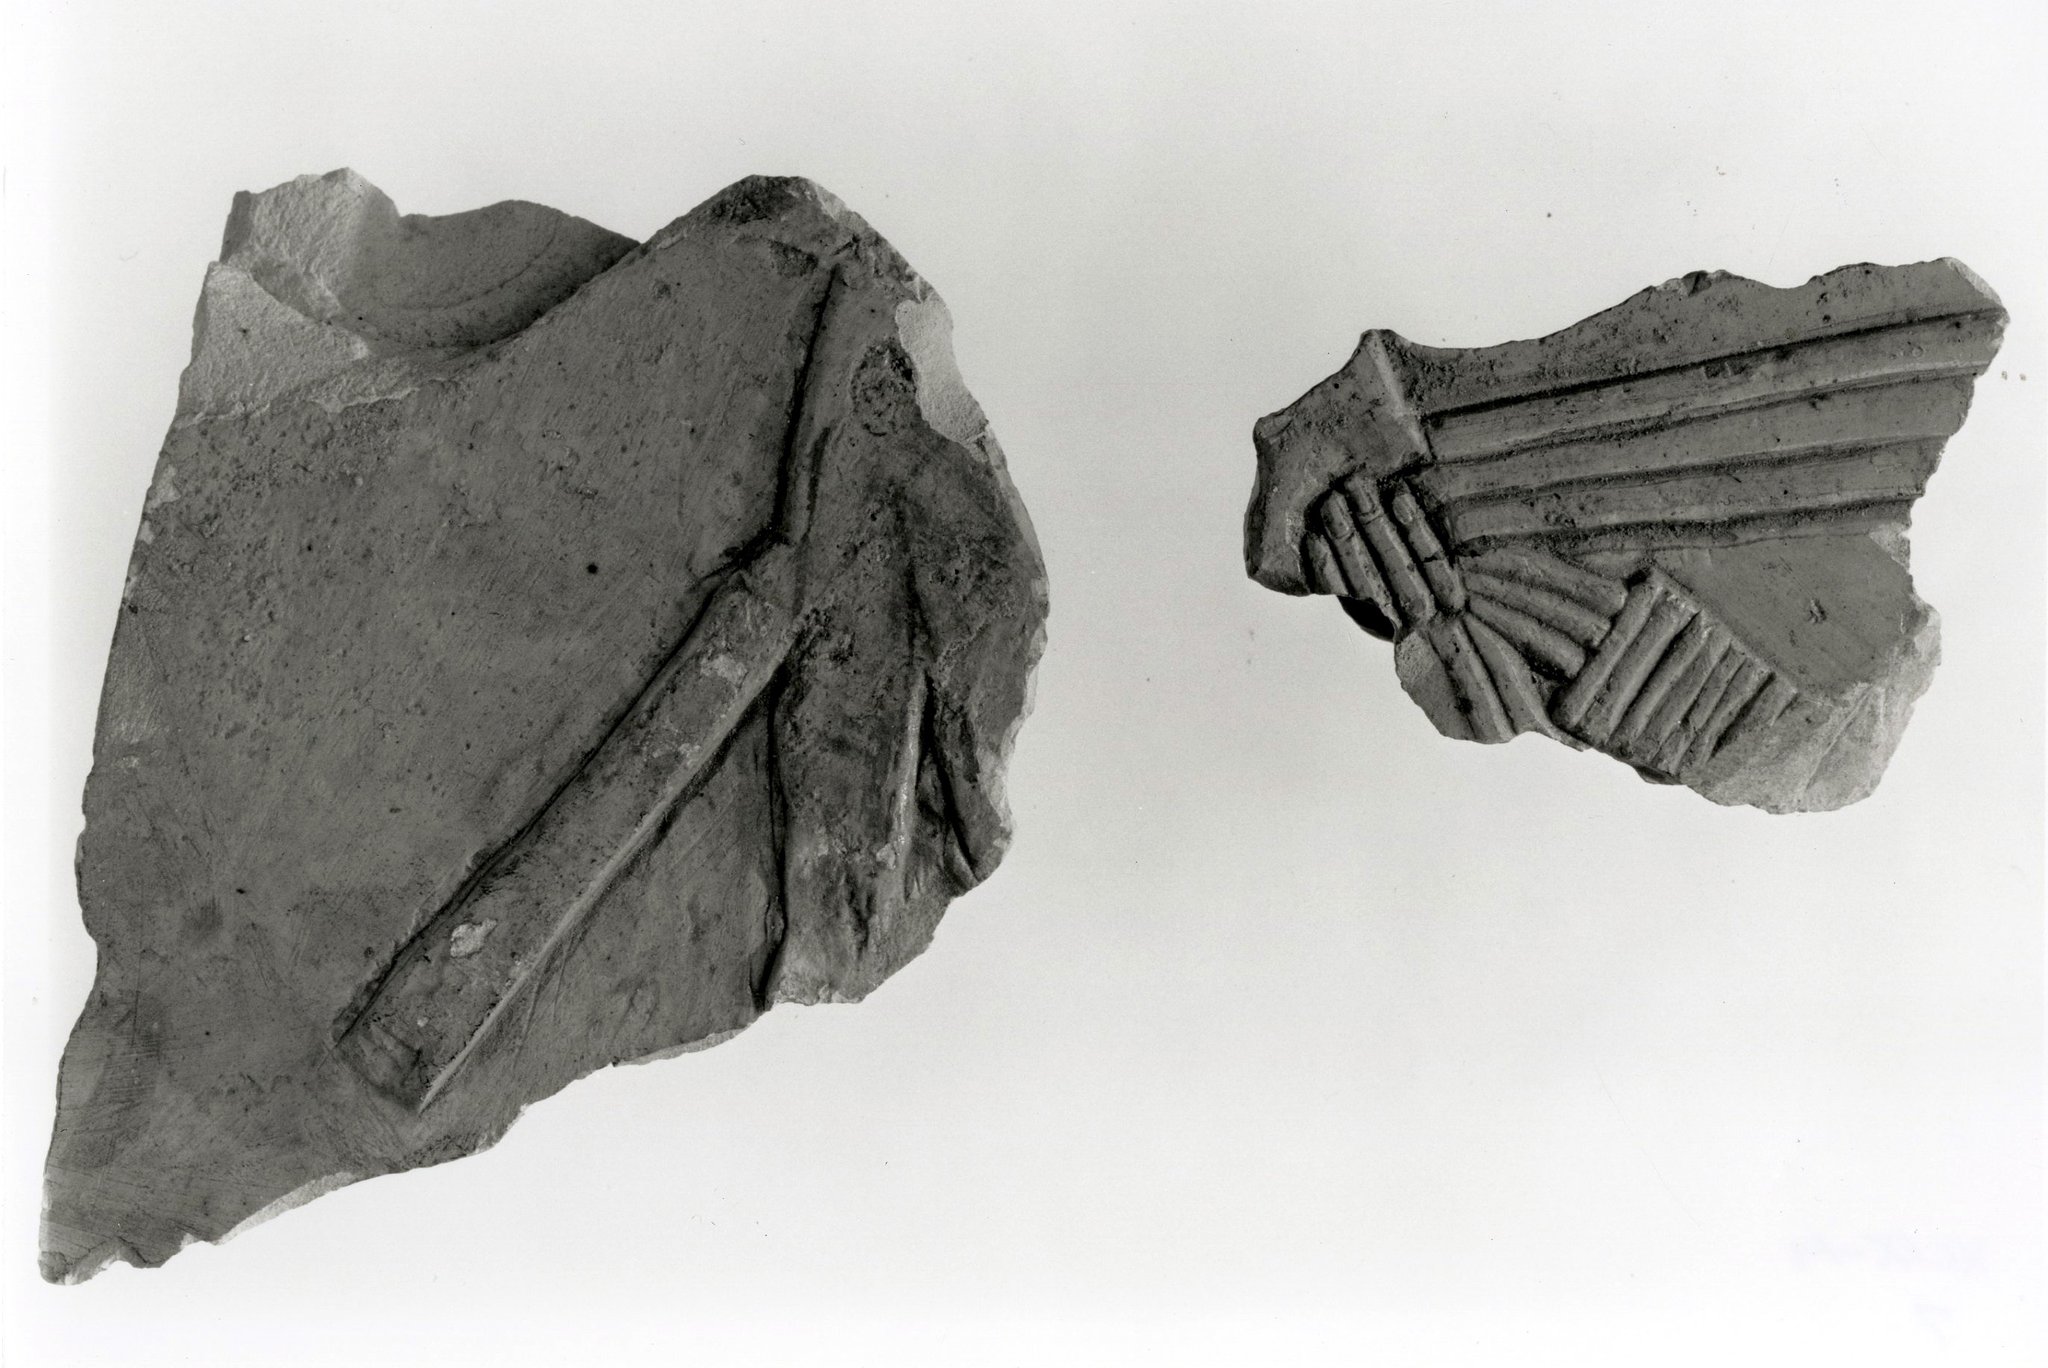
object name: relief, tomb of nespekashuty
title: Raised relief fragment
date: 664-610 BCE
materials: limestone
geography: egypt